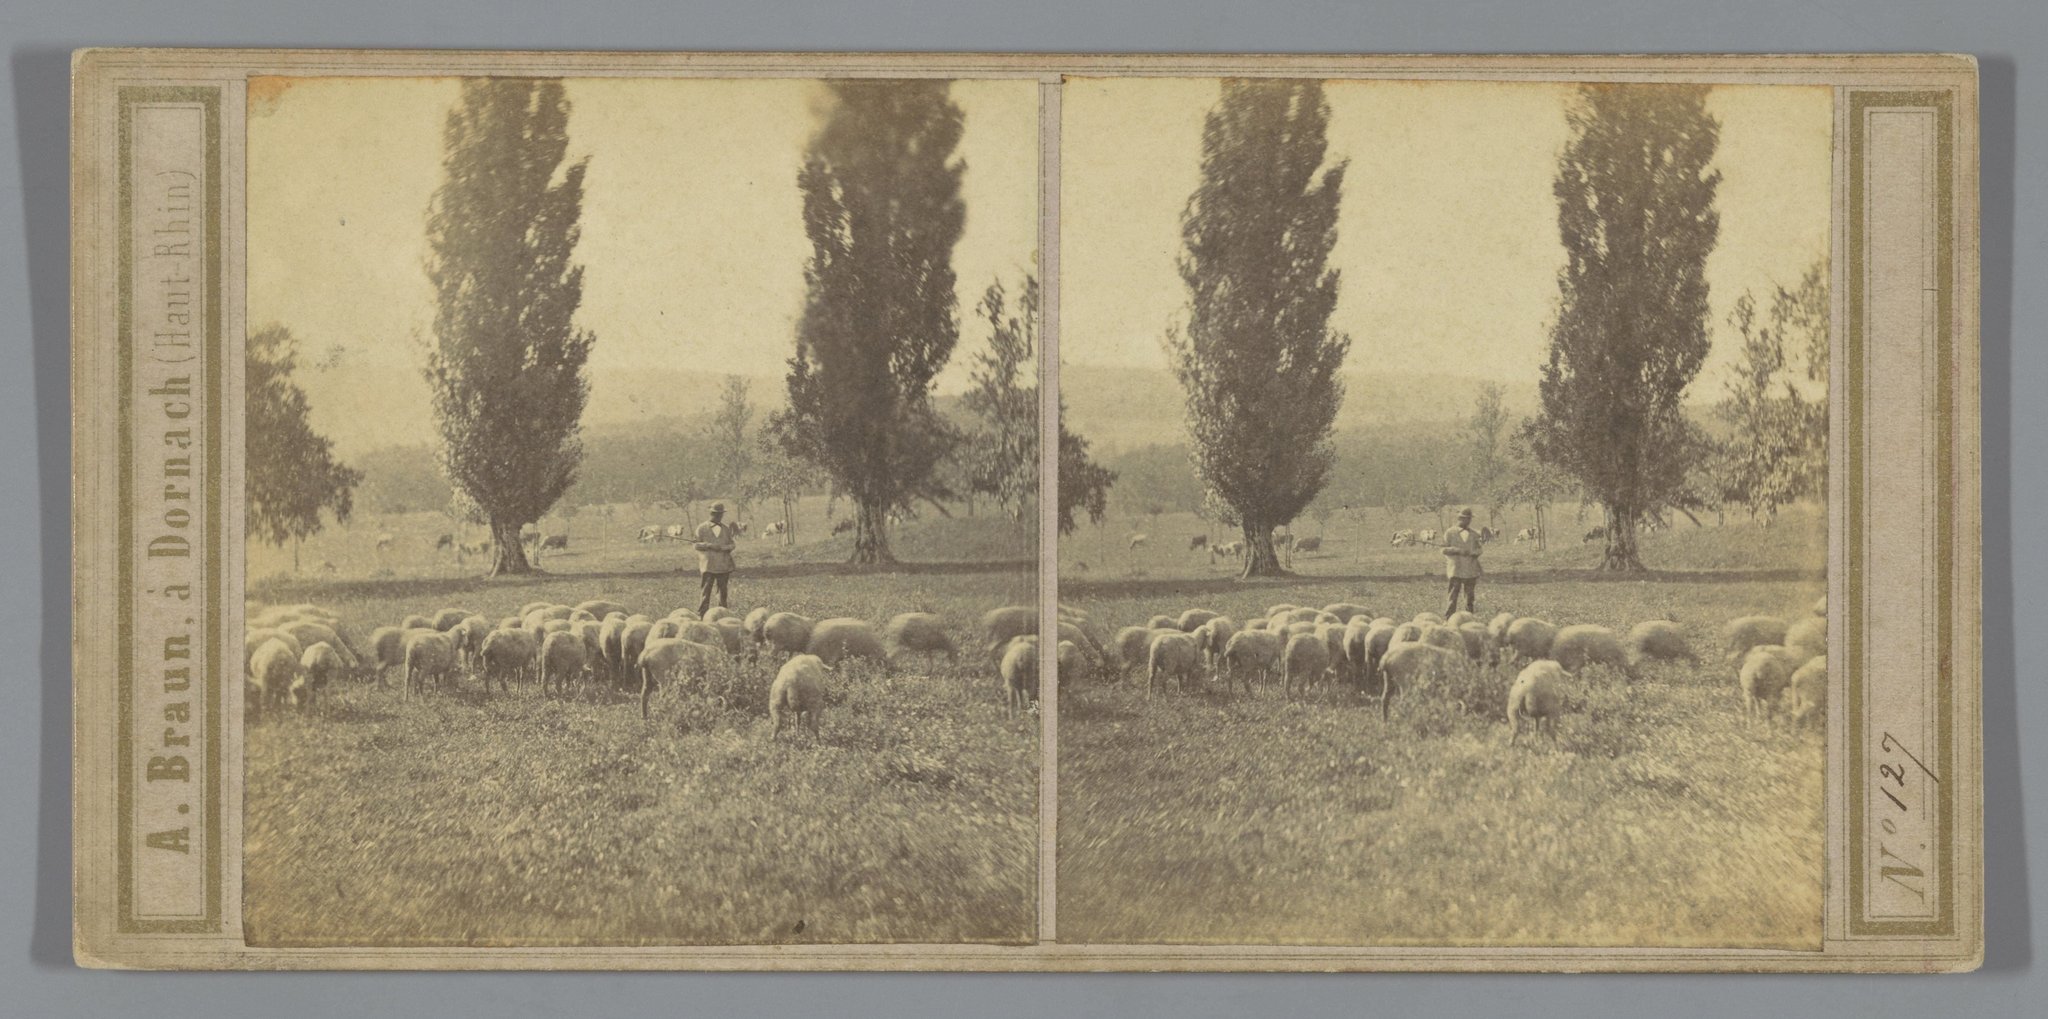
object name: stereograph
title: Schaapsherder met kudde schapen op een weide, mogelijk in Duitsland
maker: Anonymous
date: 1860-1866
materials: cardboard, paper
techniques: albumen print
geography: germany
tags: herd, flock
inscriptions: number: ‘No. 127’